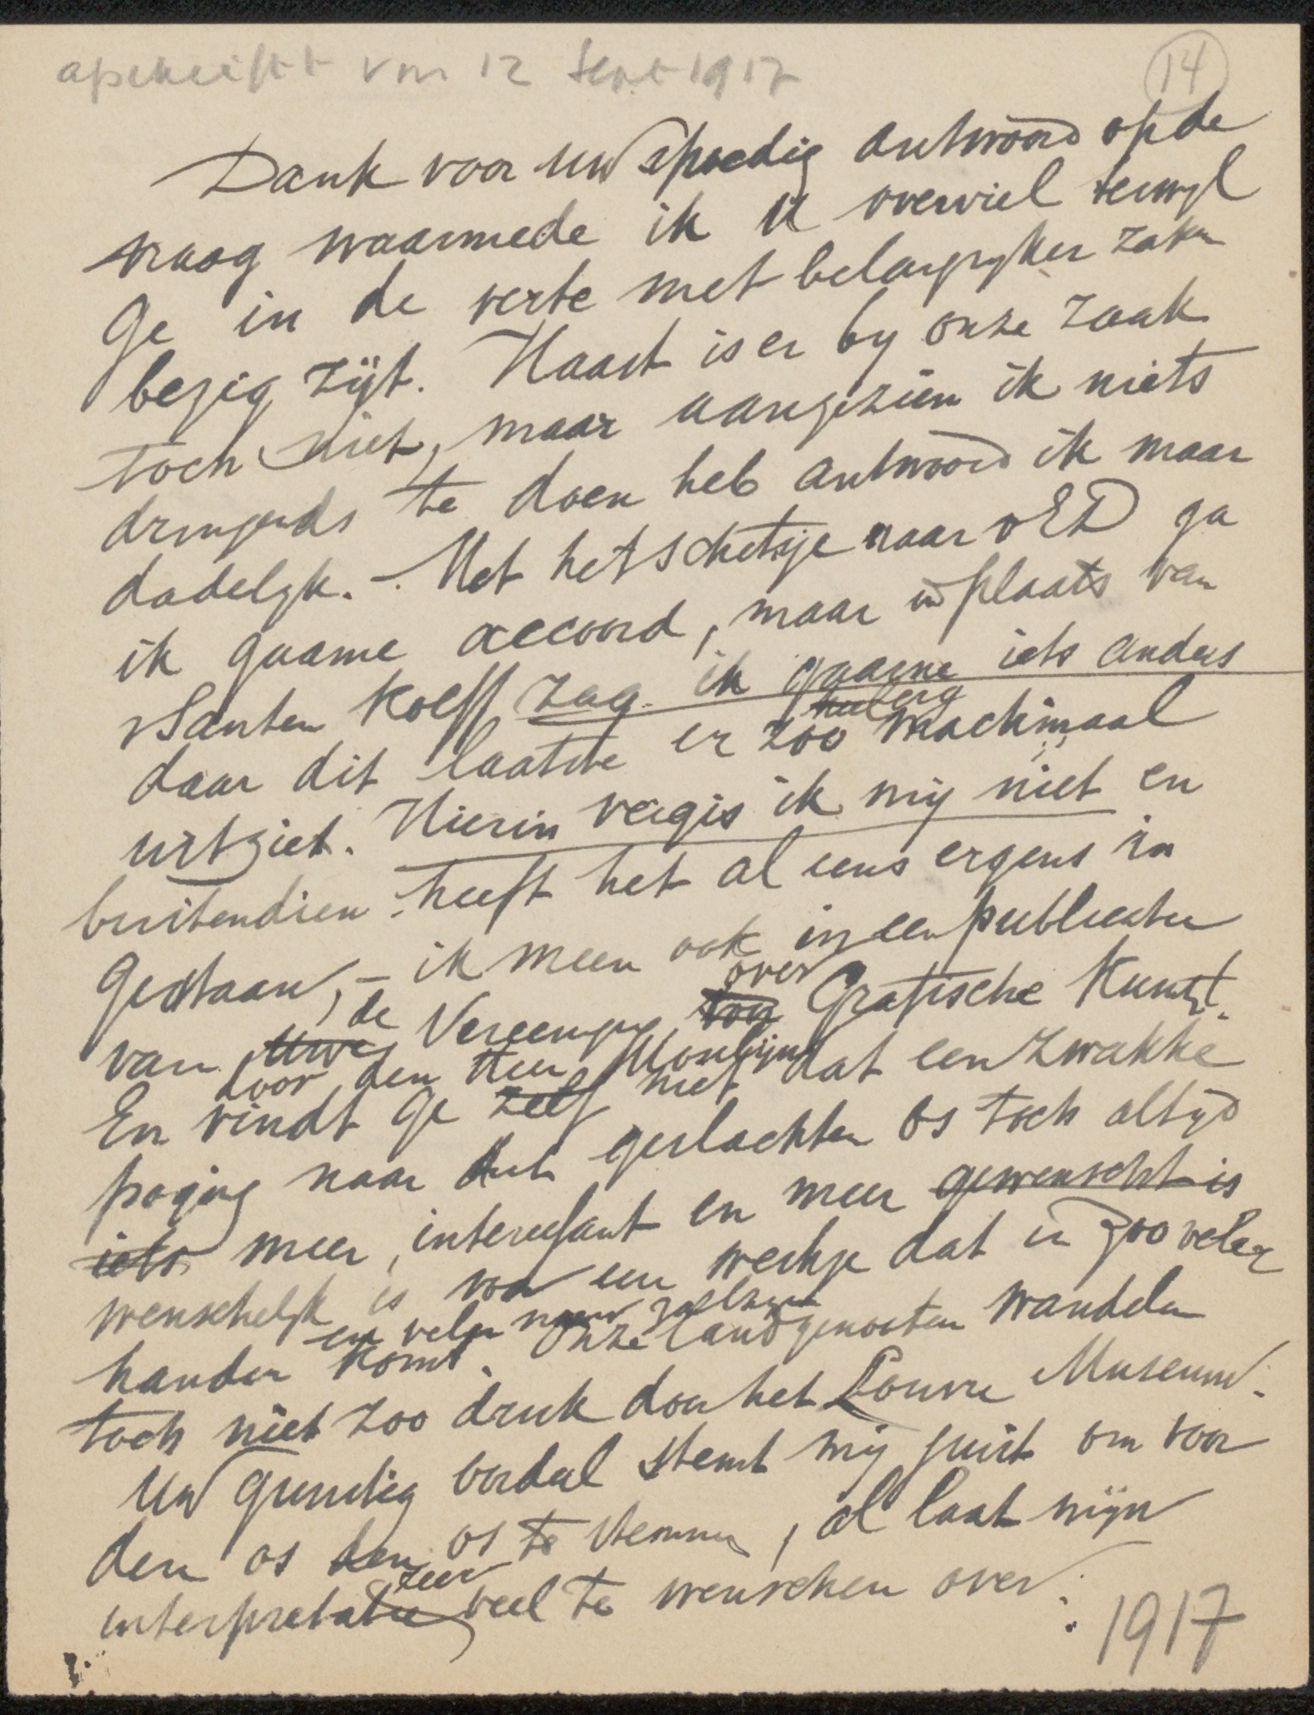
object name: letter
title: Brief aan Jan Veth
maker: august allebé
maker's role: draughtsman, print maker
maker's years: 1838-1927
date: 1848-1927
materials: ink, paper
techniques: pen, writing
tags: jan veth, haarlem, print maker, draughtsman, sjoerd hendrik de roos, amsterdam, louis van erven dorens, rotterdam, painter, anonymous historical person portrayed, middelburg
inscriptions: collector's mark: ‘RPK’